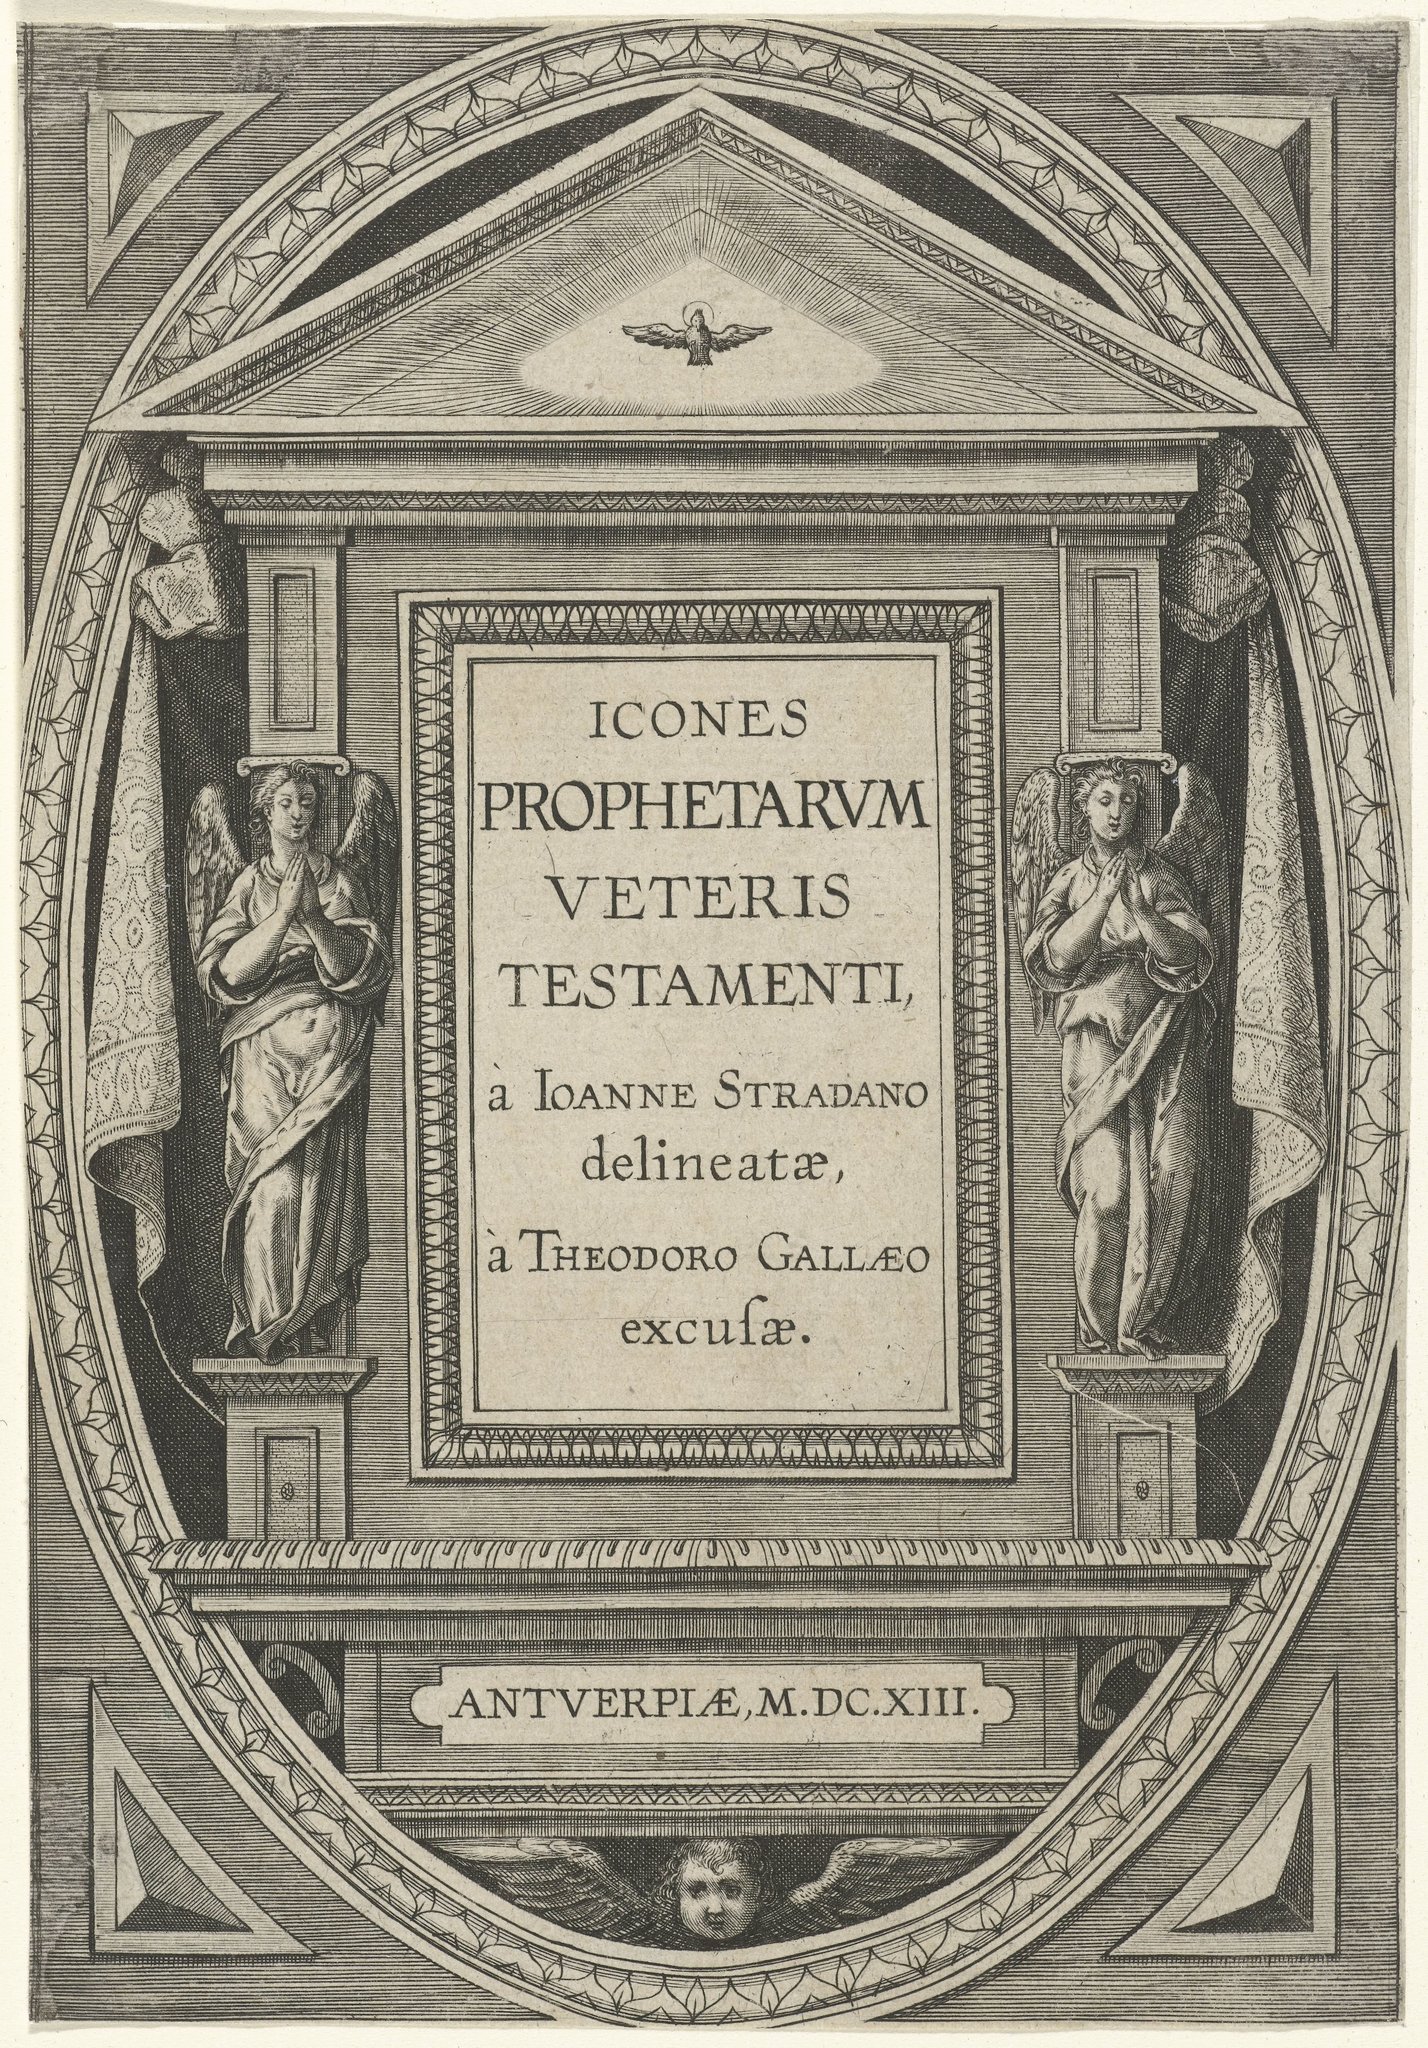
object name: print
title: Icones Prophetarum Veteris Testamenti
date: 1613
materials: paper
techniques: engraving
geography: antwerp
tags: holy ghost represented as a dove (in flames)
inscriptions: date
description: Titelprent voor serie van 27 prenten met profeten uit het Oude Testament. Titel van de serie in architecturale omlijsting.